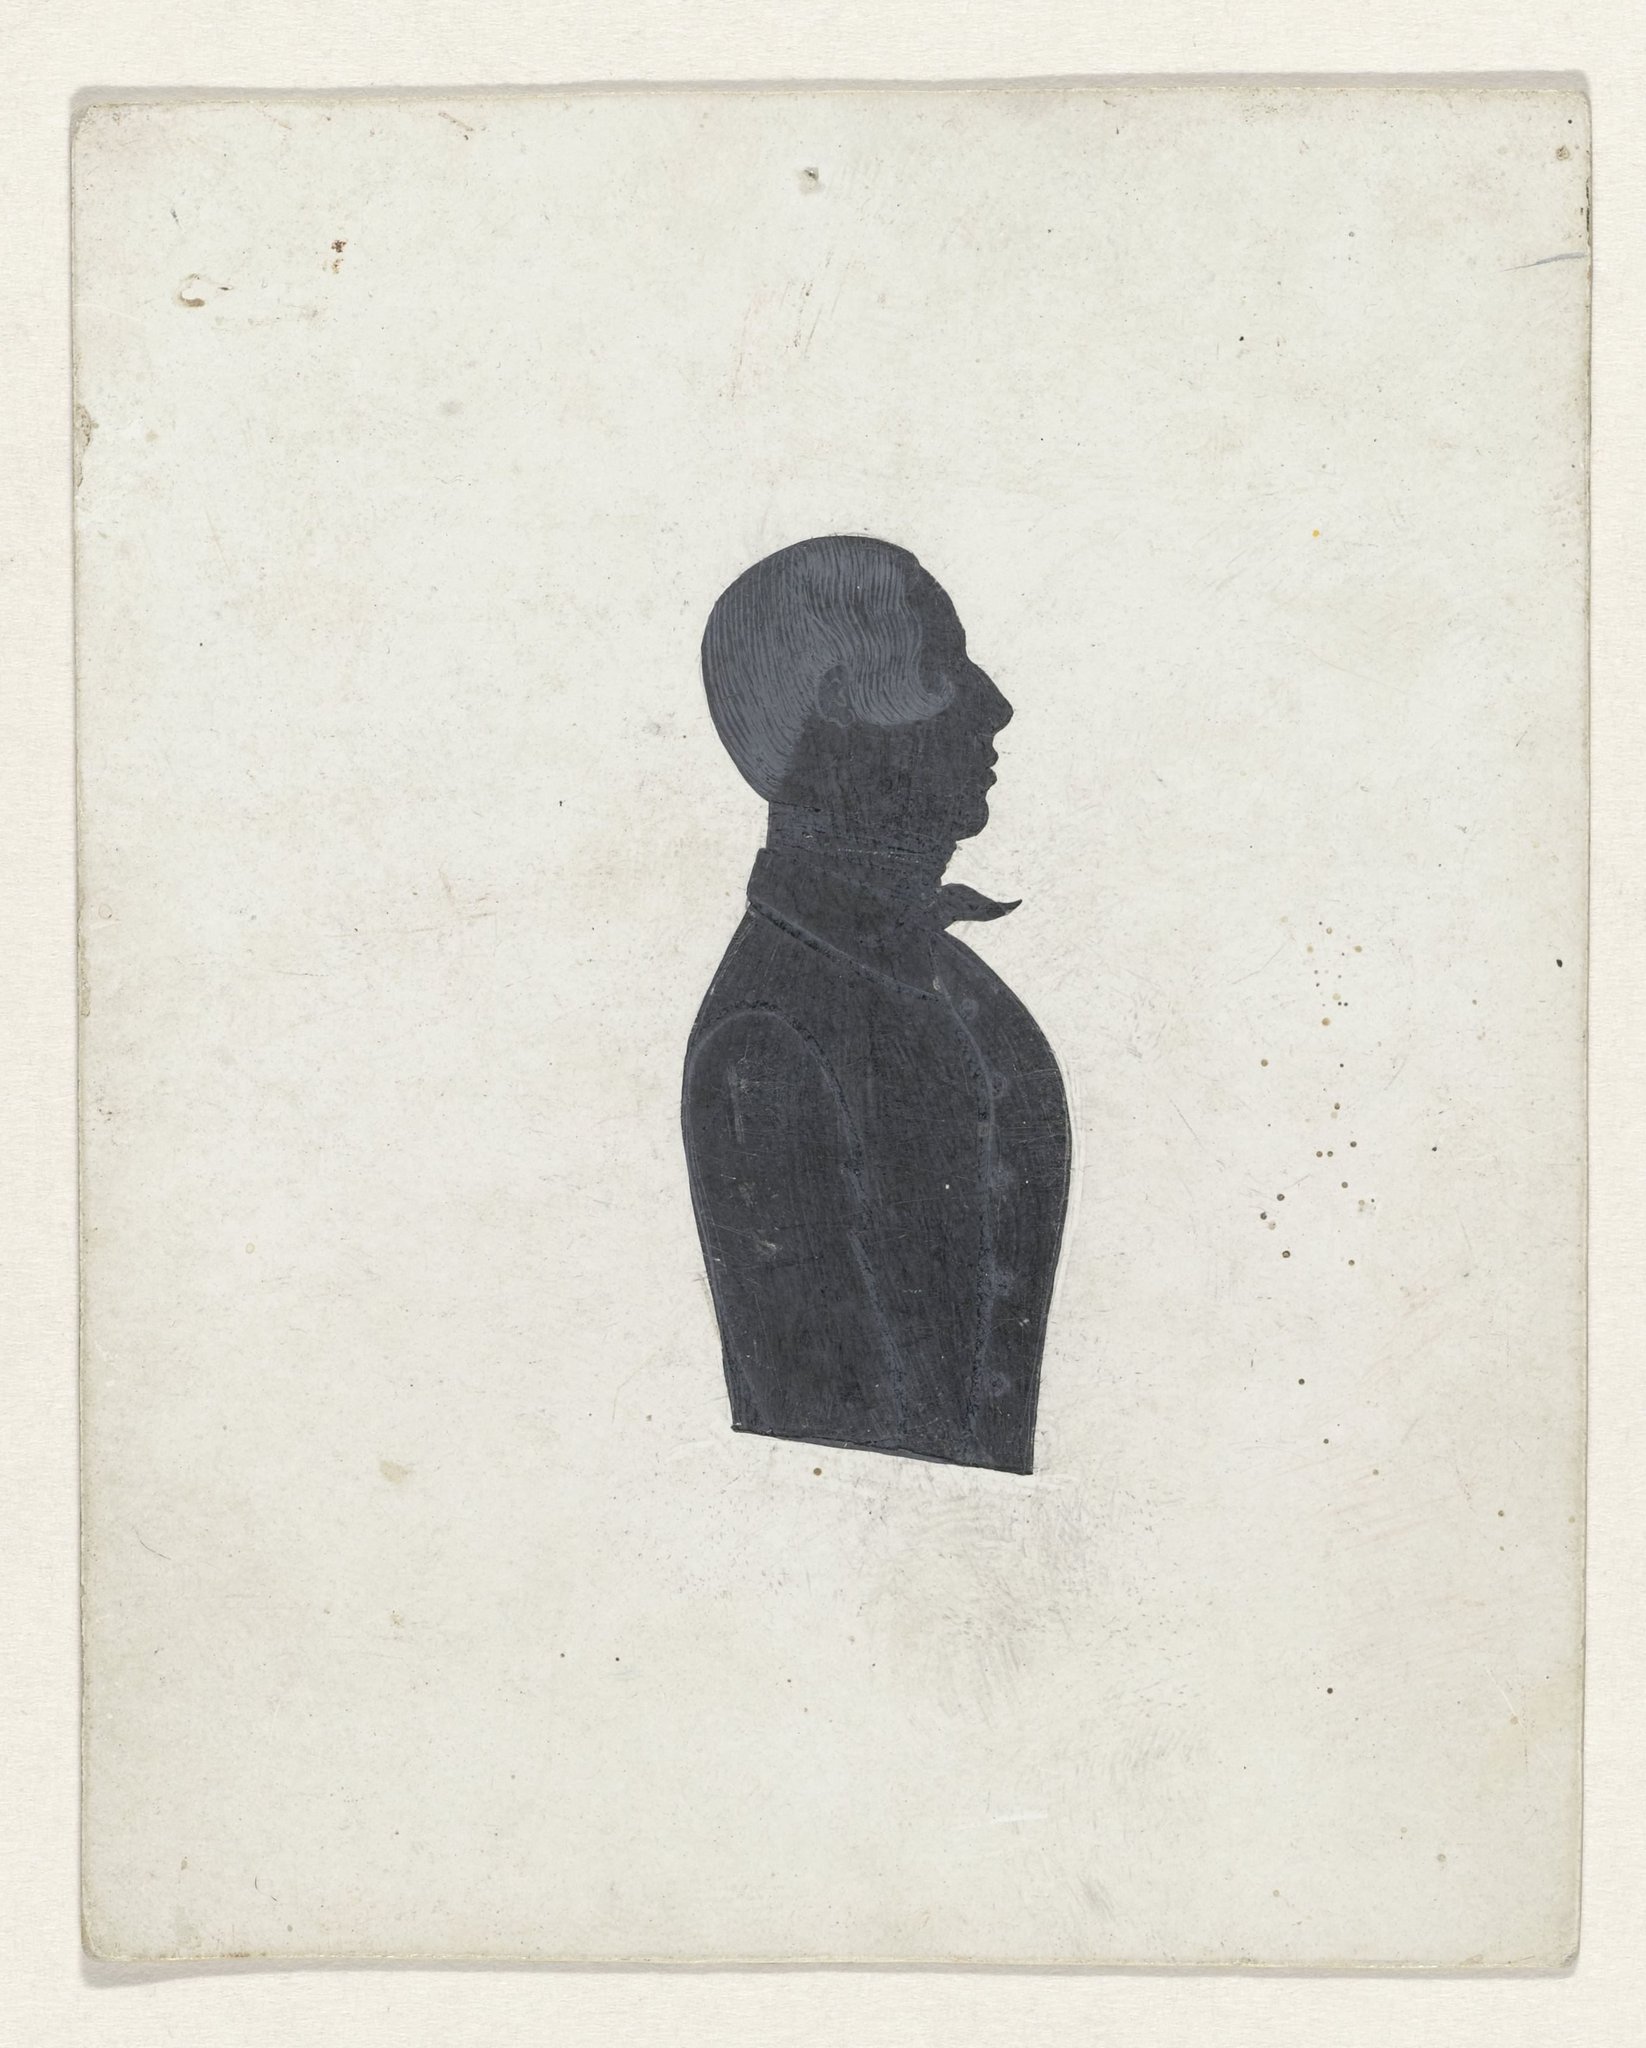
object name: silhouette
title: Portret van Mozes Meijer de Hart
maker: Anonymous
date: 1820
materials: paint, paper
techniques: brush, snipping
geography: paramaribo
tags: amsterdam, historical persons (portraits and scenes from the life), suriname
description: Silhouet portret van Mozes Meijer de Hart, de vader van Maria Louisa de Hart.